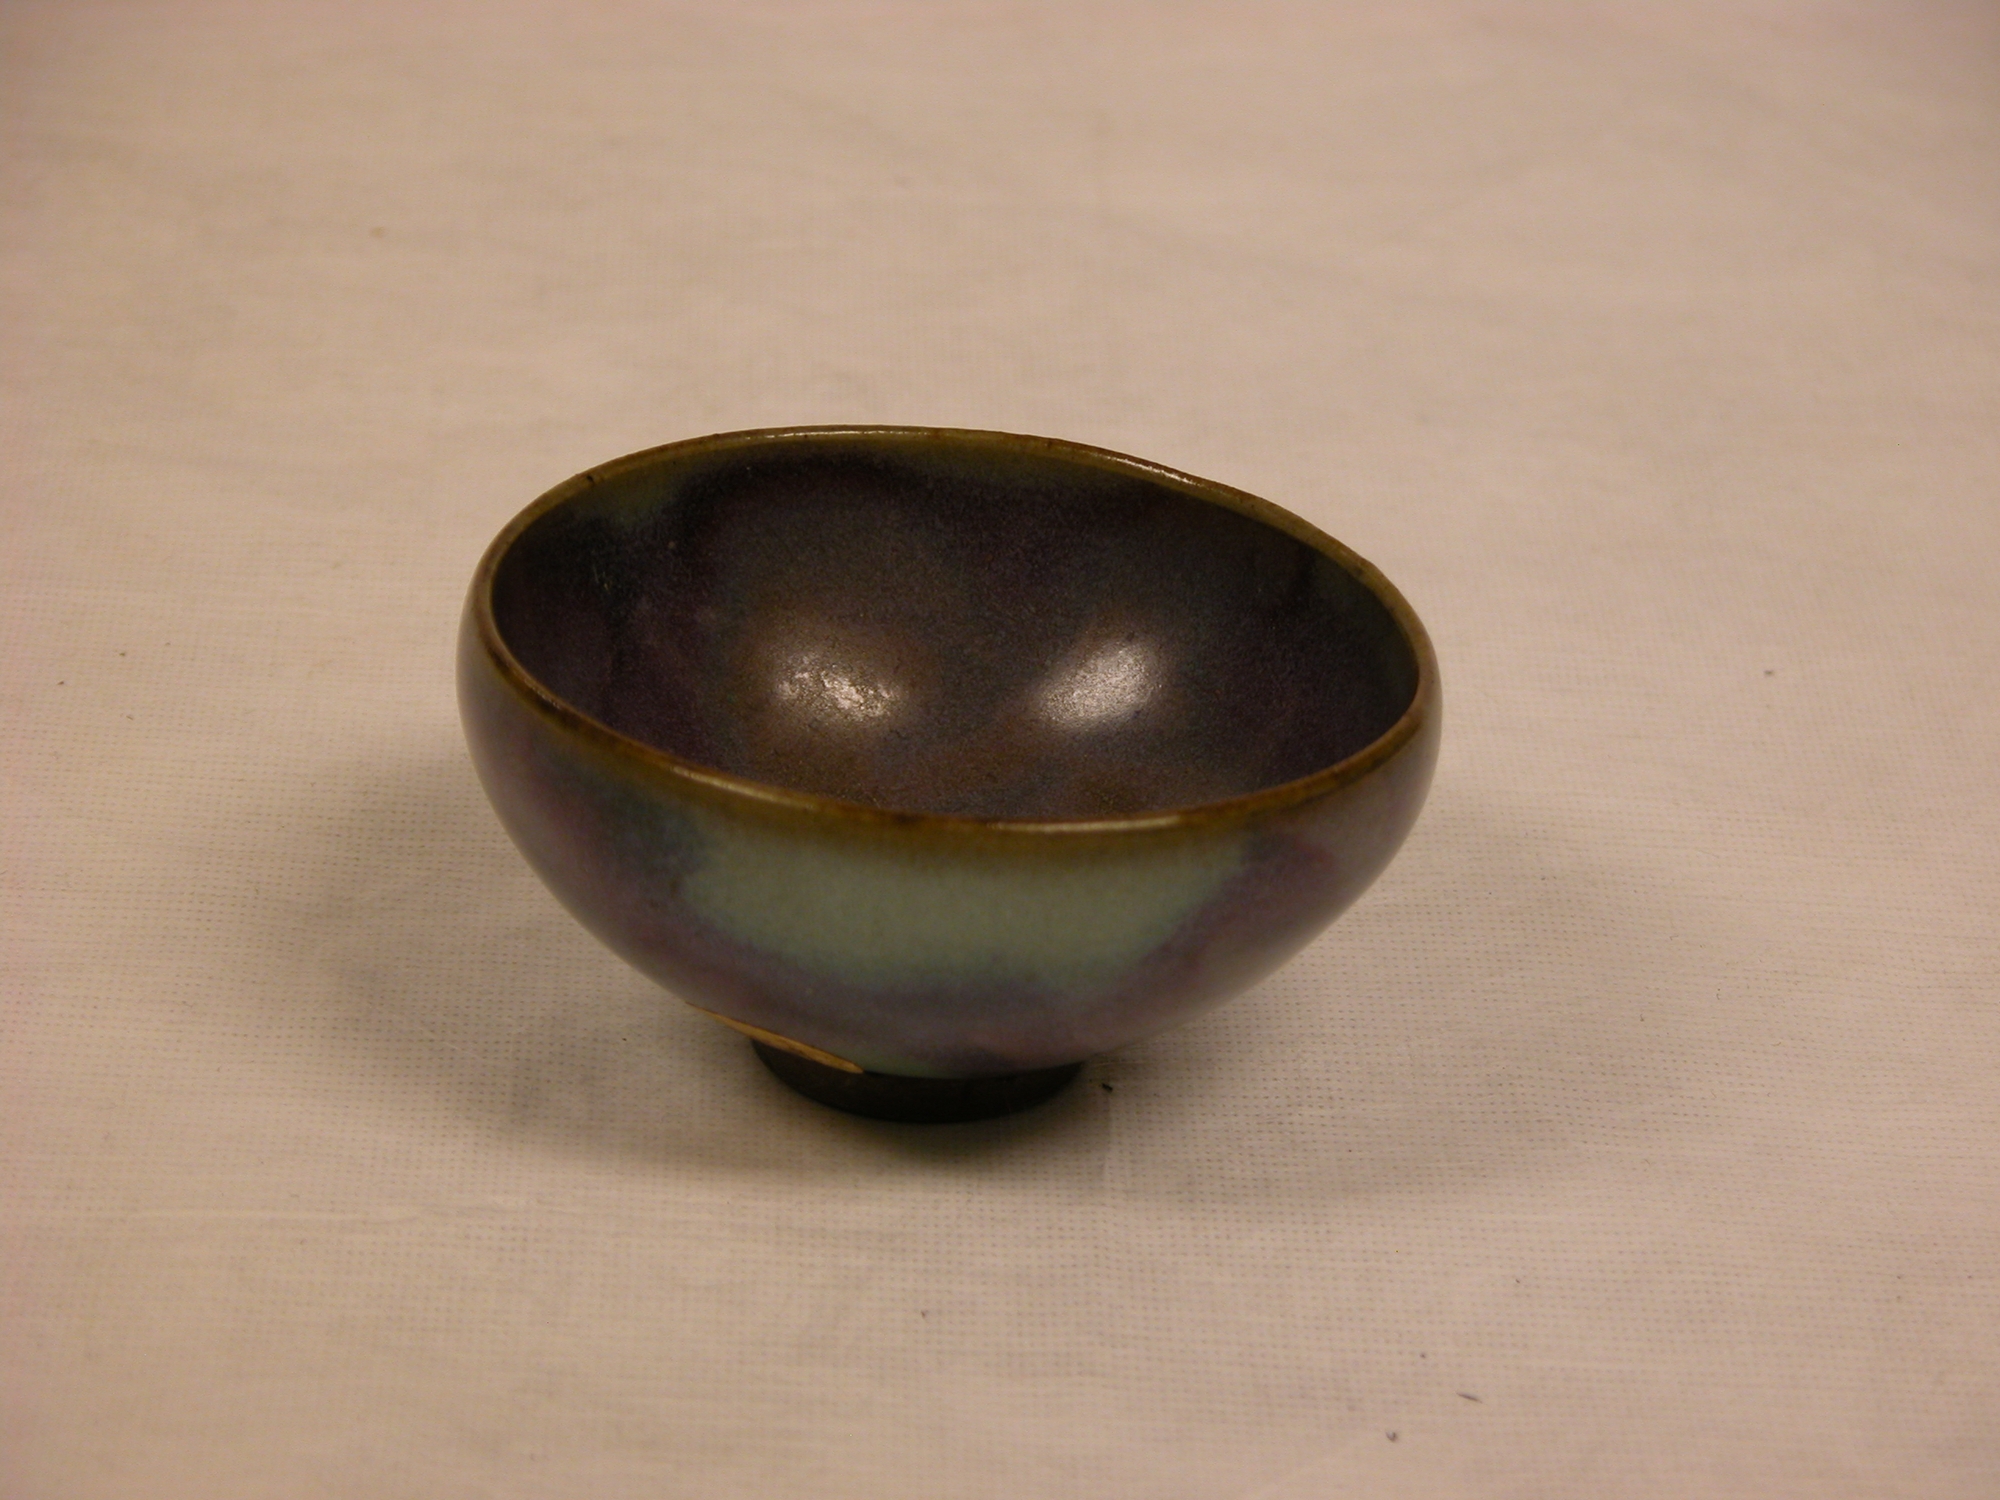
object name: bowl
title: Small bowl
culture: chinese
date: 1115-1234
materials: glaze, stoneware